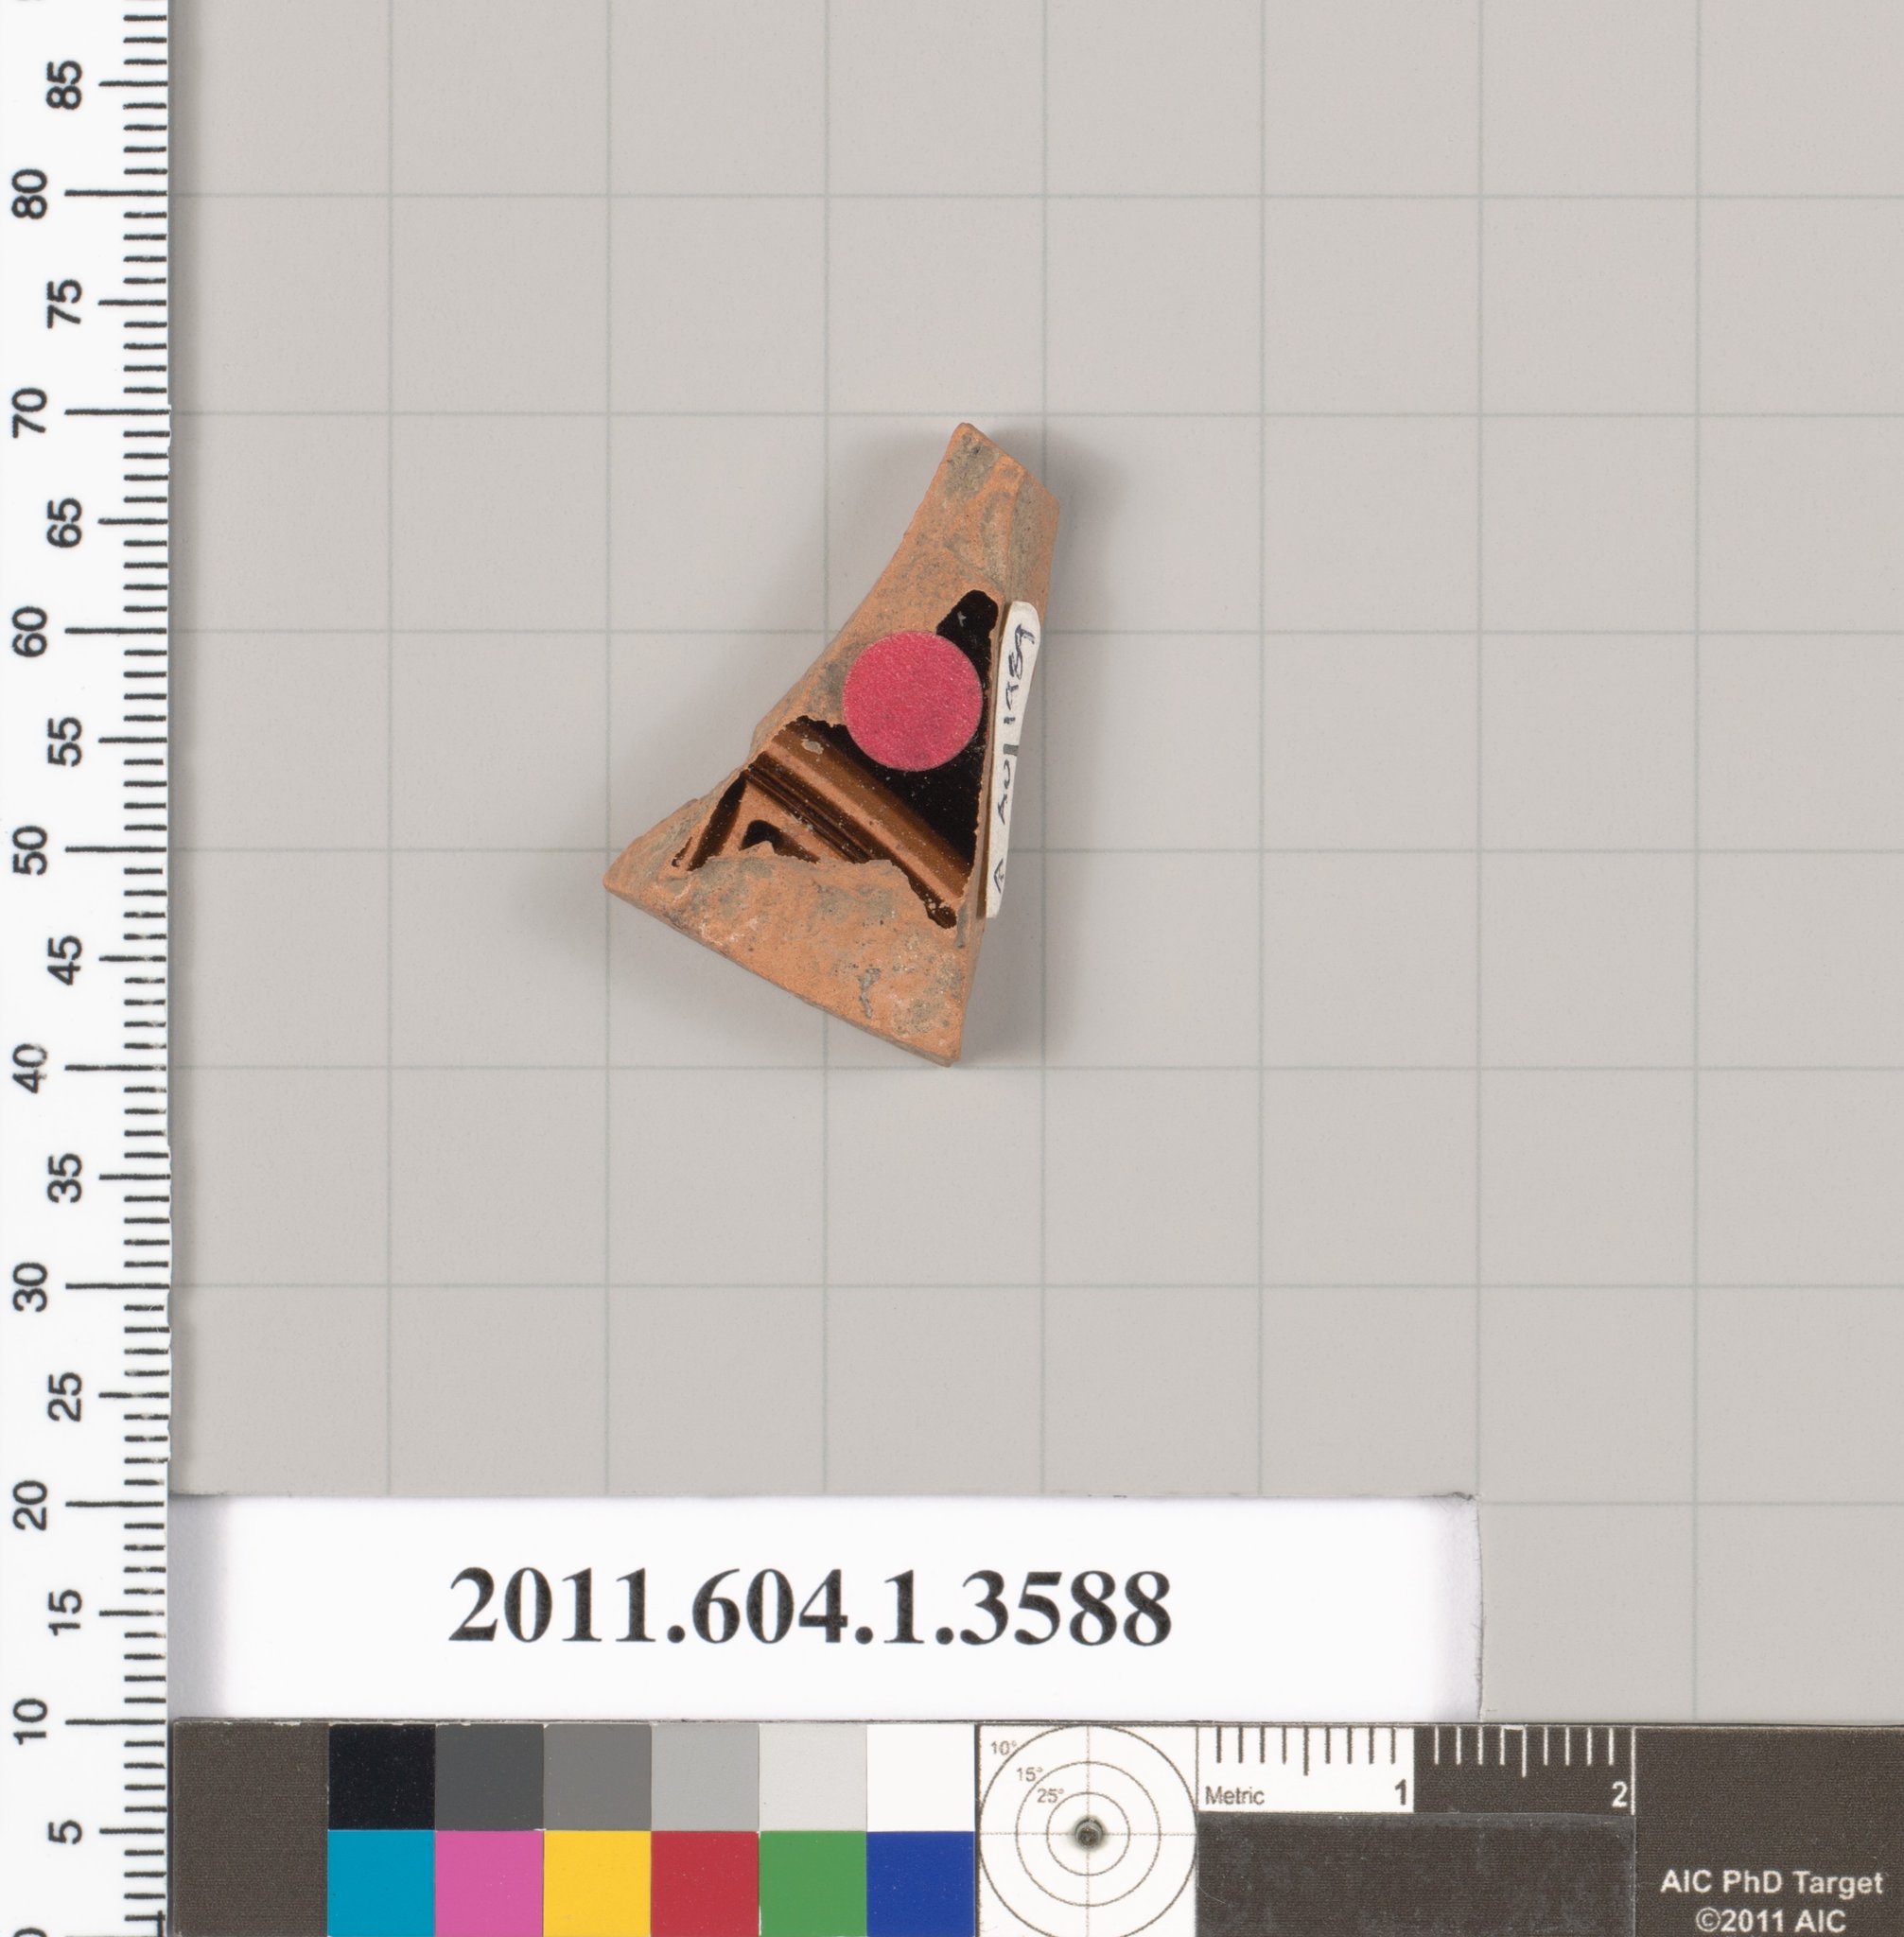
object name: kylix fragment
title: Terracotta fragment of a kylix (drinking cup)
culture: greek, attic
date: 475-451 BCE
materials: terracotta